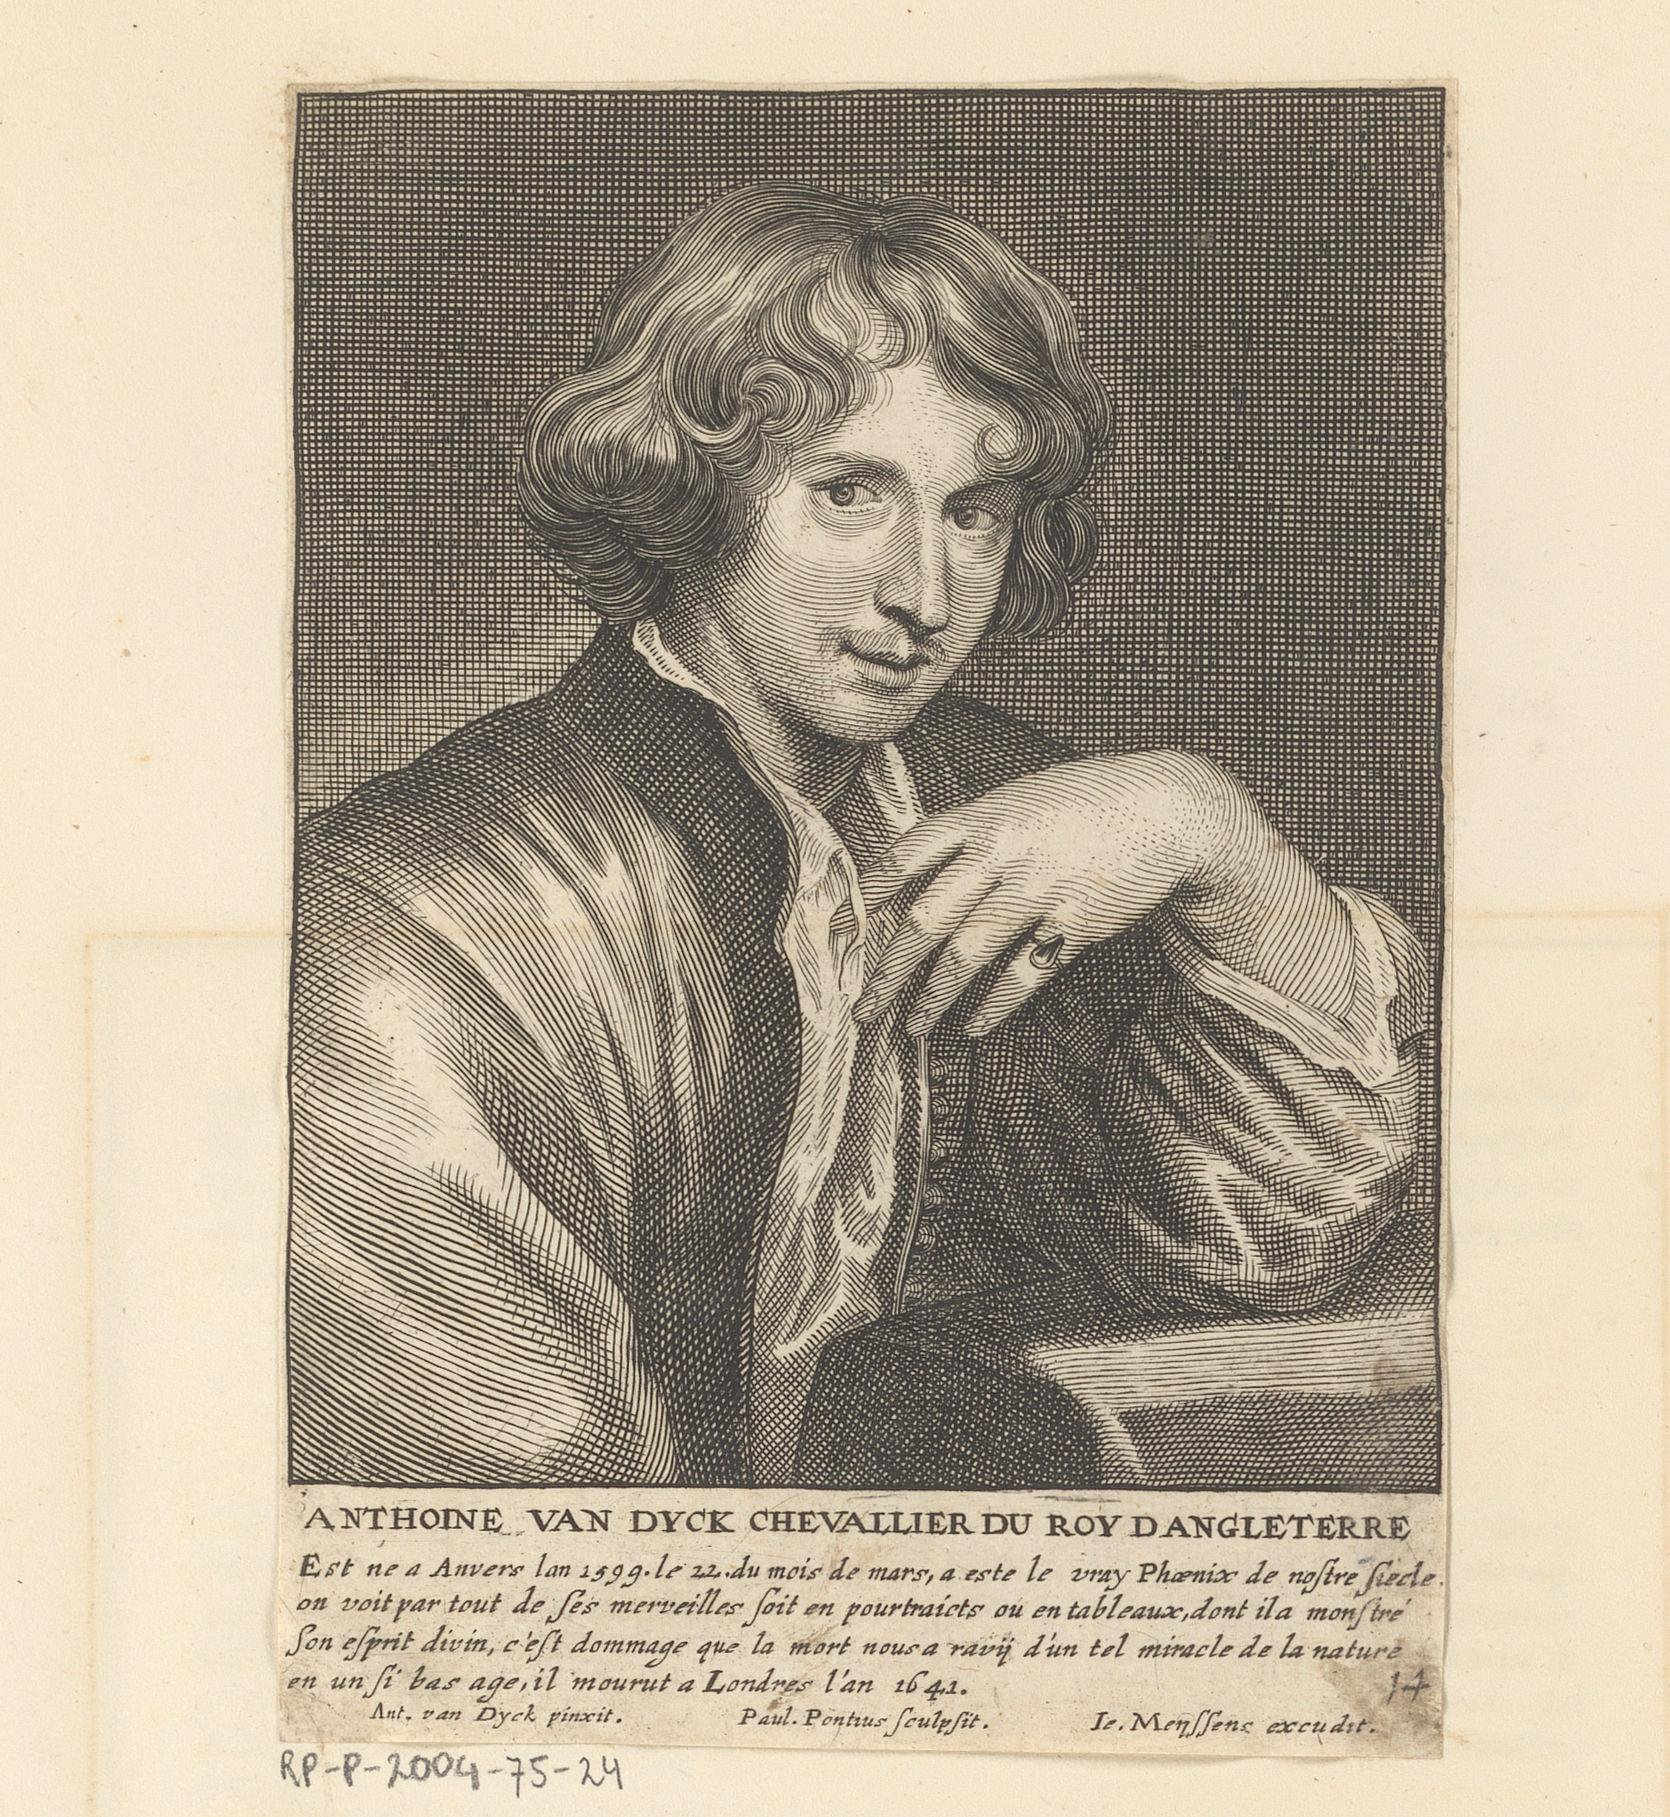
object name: print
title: Portret van Anthony van Dyck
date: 1649-1662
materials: paper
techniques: engraving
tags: antwerp, london, painter, print maker, draughtsman, anthony van dyck, historical persons, portrait, self-portrait of painter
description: Huidige staat van prent (genummerd 14) gebruikt in: The Portraits of the Most Eminent Painters, and other Famous Artists (...). Londen: Olive Payne, 1739. Eerste bekende staat (ongenummerd) gebruikt in: Bie, Cornelis De. Het gulden Cabinet vande edel vry schilder const, inhoudende den lof vande vermarste schilders, architecte, beldthowers ende plaetsnyders van dese eeuw. Antwerpen: Joannes Meyssens, 1662 [1661 foutief op titelpagina], p. 141. En mogelijk ook al in: Meyssens, Joannes. Image de divers hommes desprit sublime qui par leur art et science deburovent vivre eternellement et des quels la louange et renommée faict estonner le monde. 2 dln. Antwerpen: Joannes Meyssens, 1649. Tweede bekende staat (genummerd 33) gebruikt in: Resta, Sebastiano. The true effigies of the most eminent painters and other famous artists that have flourished in Europe. Londen, 1694. De samensteller heeft deze prent in het album geplakt als illustratie bij: Pilkington, Matthew en Johann Heinrich Füssli. A dictionary of painters, from the revival of the art to the present period. 4 dln. Londen: John Crowder, 1805, dl. 4, p. 577.